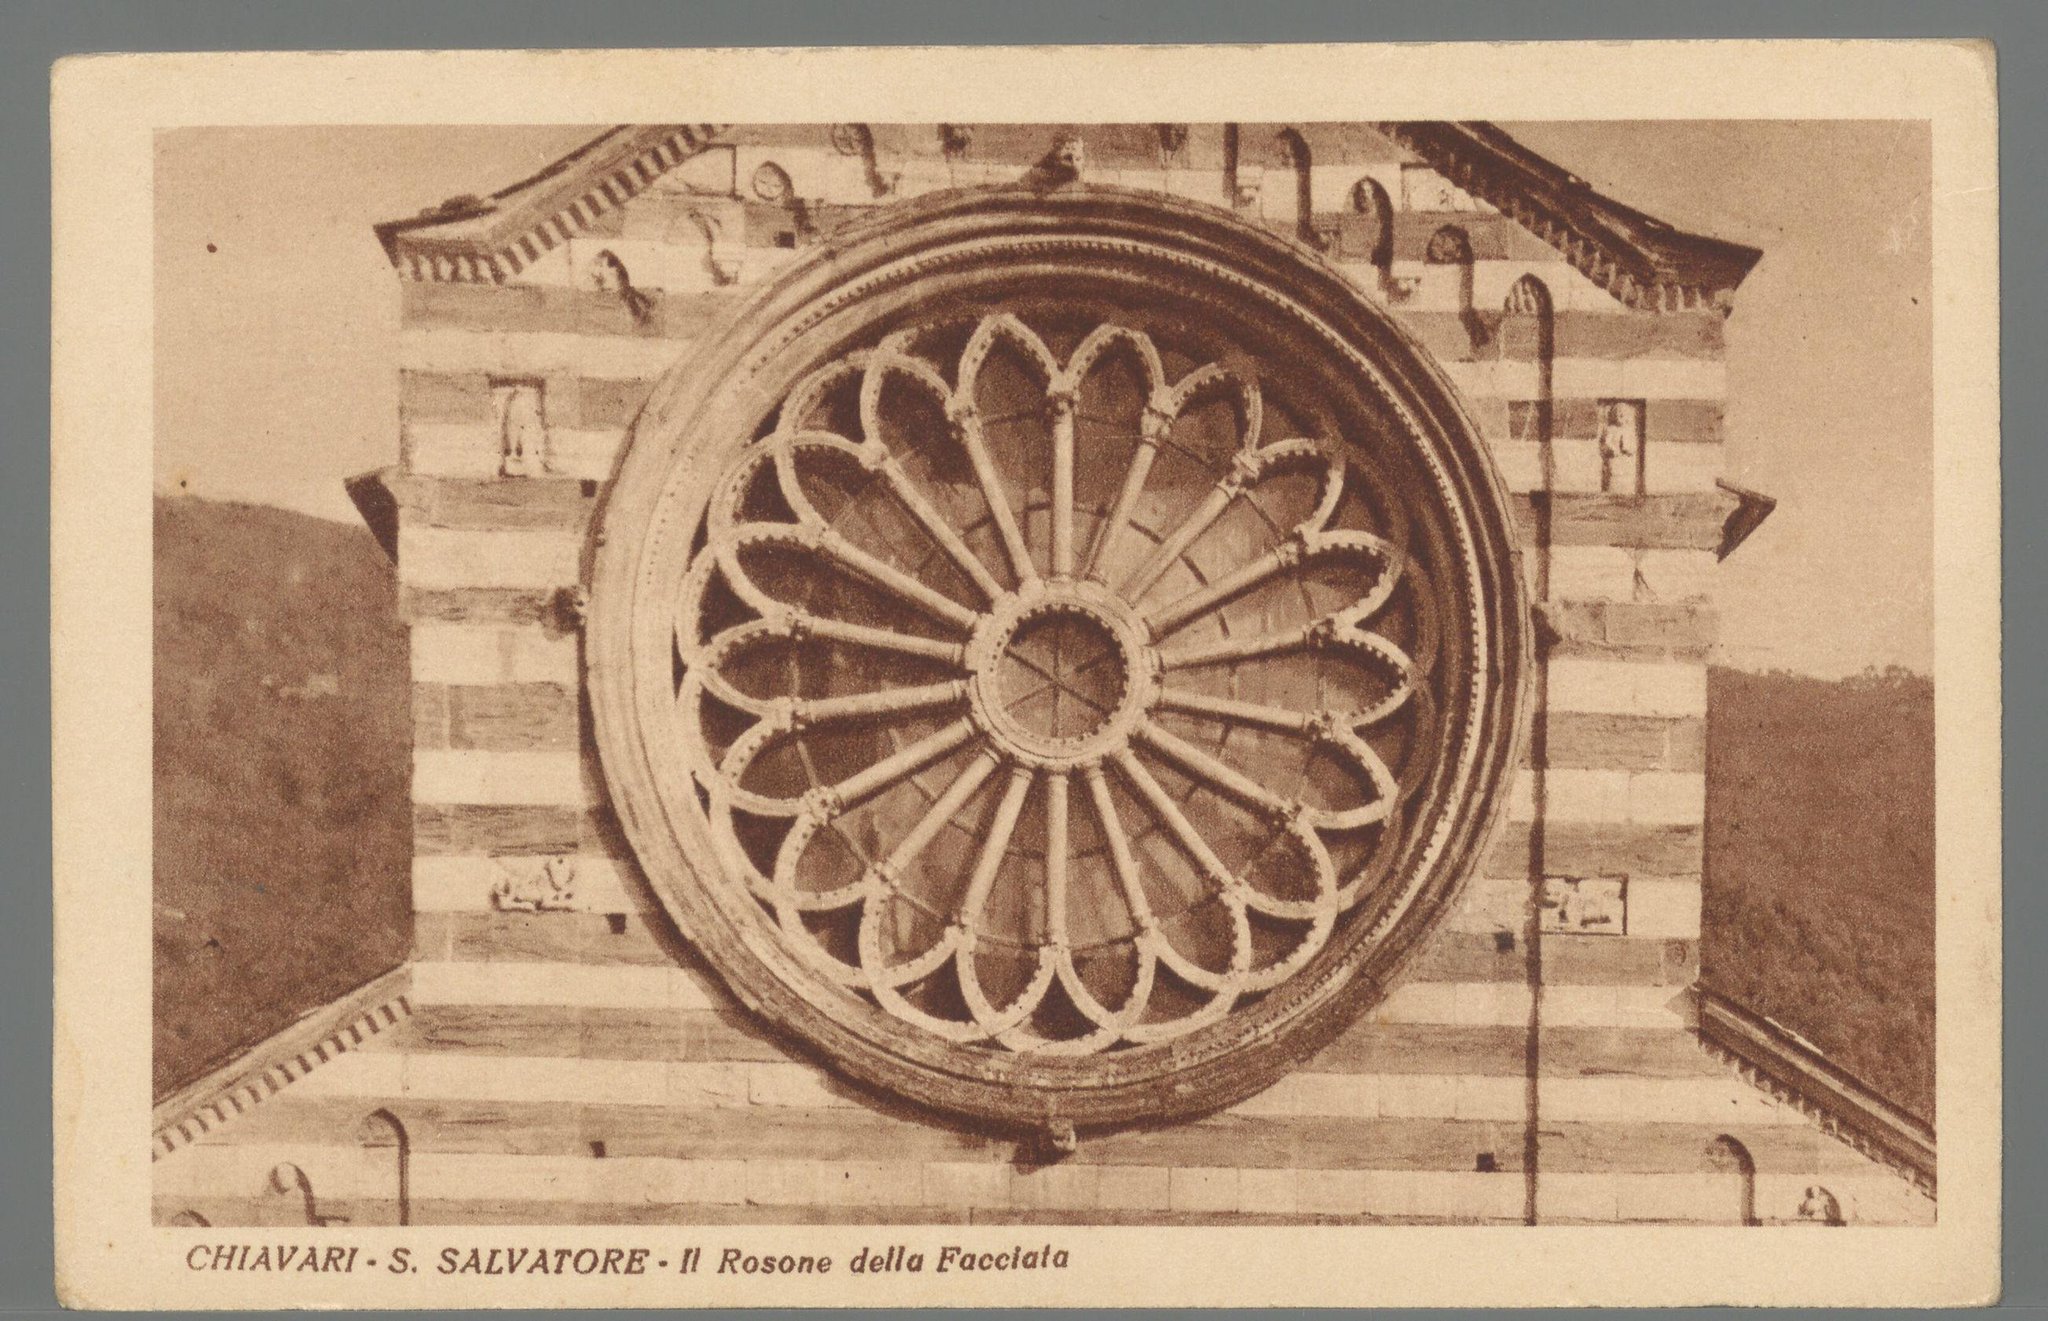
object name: ansichtkaart, prentbriefkaart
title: Chiavri. S. Salvatore. Il Rosone della Facciata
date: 1906-1930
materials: cardboard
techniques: rotogravure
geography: chiavari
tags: church (exterior)